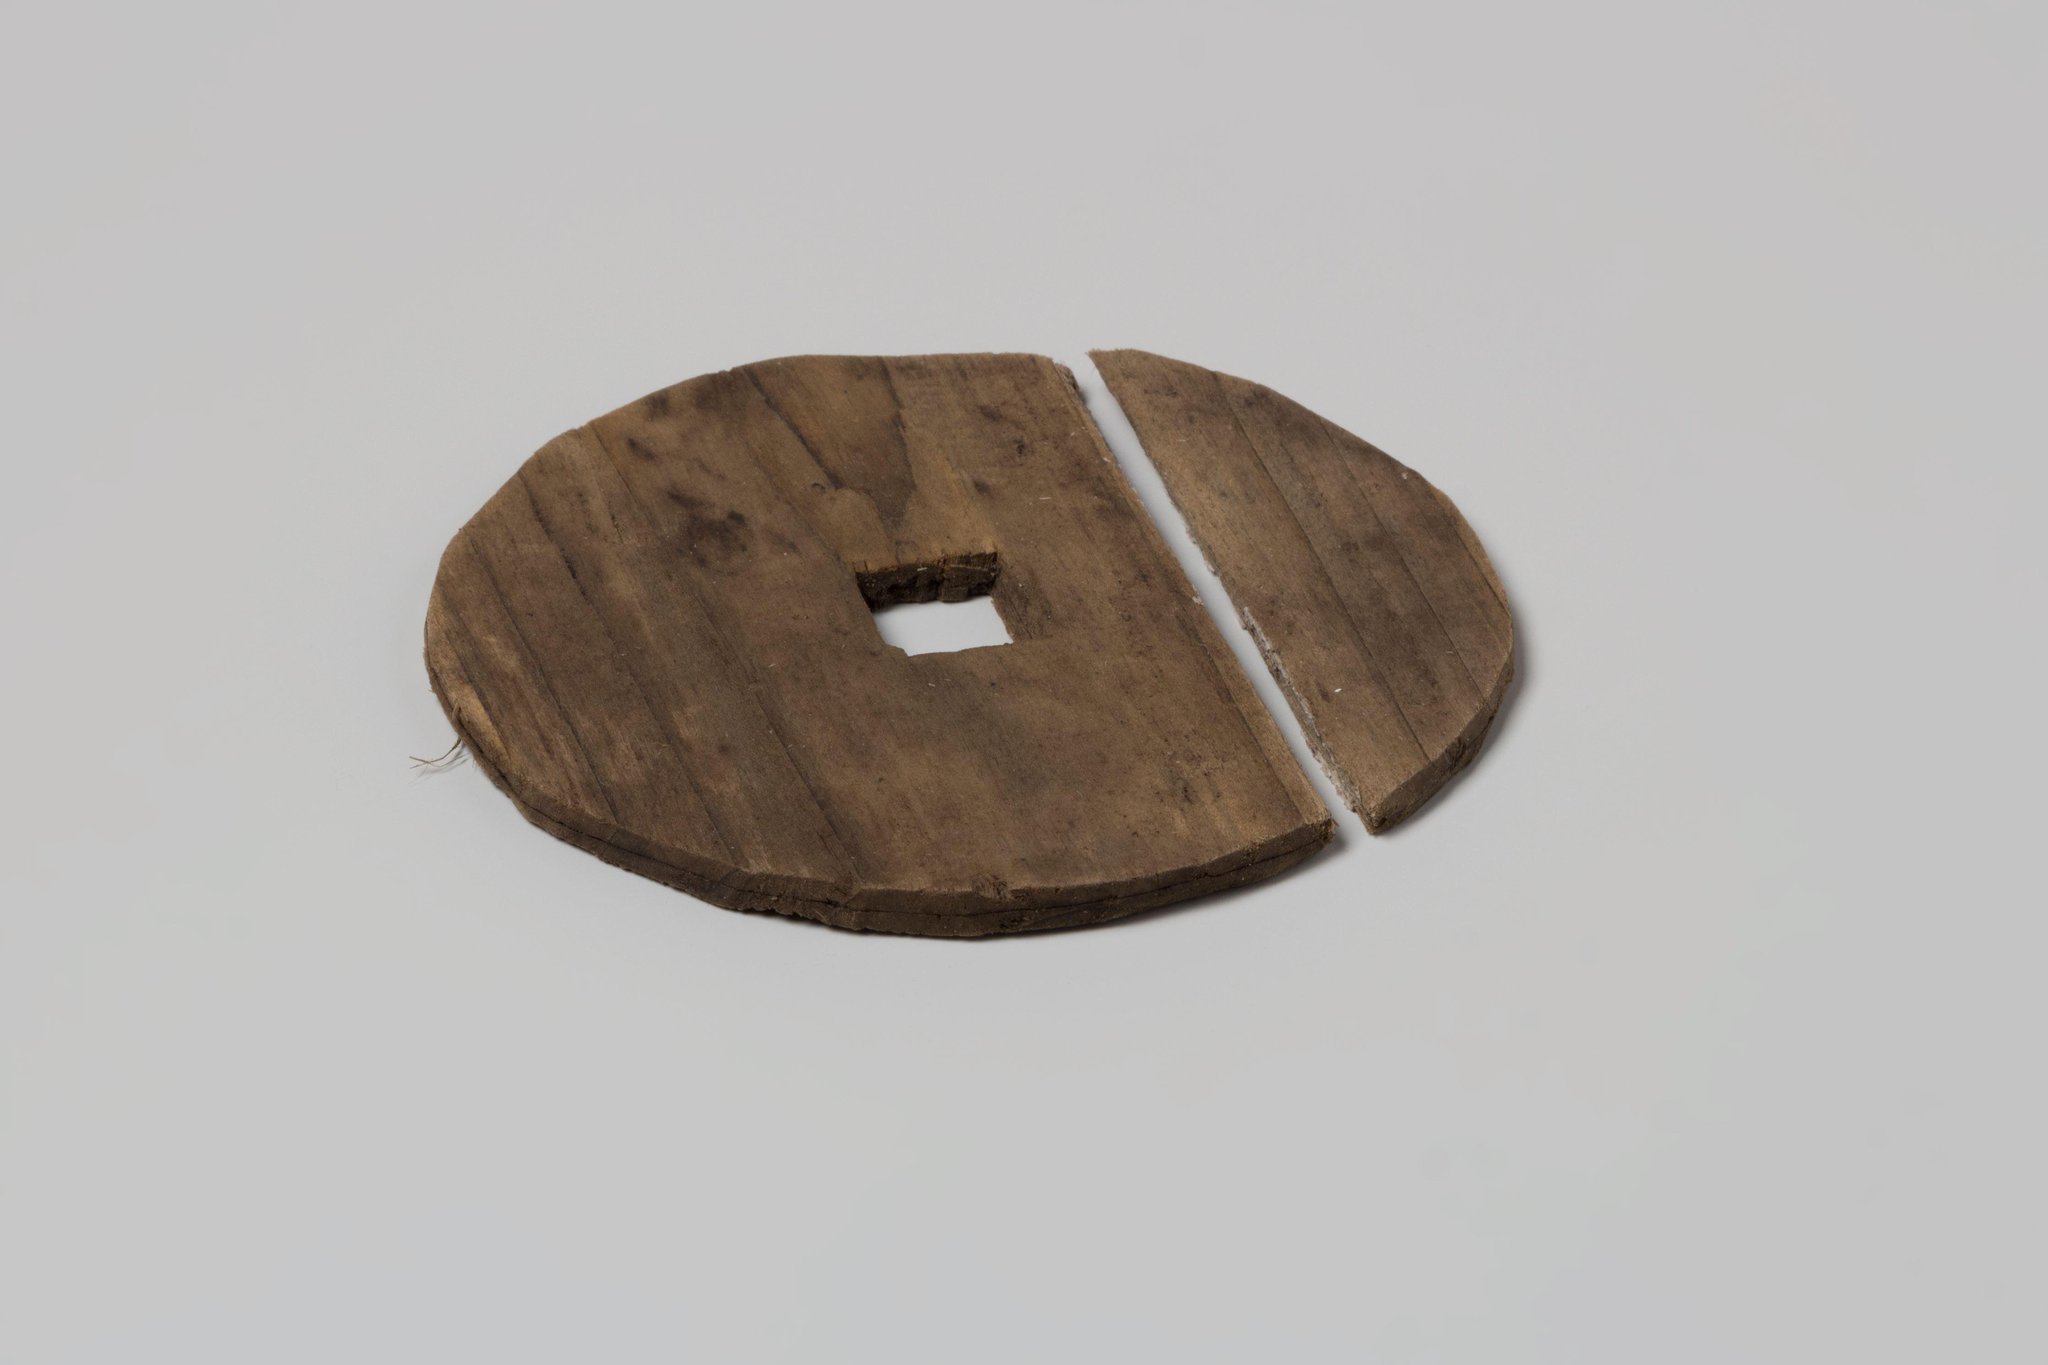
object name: disk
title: Schijf voor verpakking uit V.O.C.-schip de 'Witte Leeuw'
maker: Anonymous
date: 1613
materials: wood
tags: verenigde oostindische compagnie, sint-helena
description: Schijf voor verpakking uit V.O.C.-schip de 'Witte Leeuw'. De schijf heeft in het midden een vierkant gat. De schijf is in tweeën gespleten.